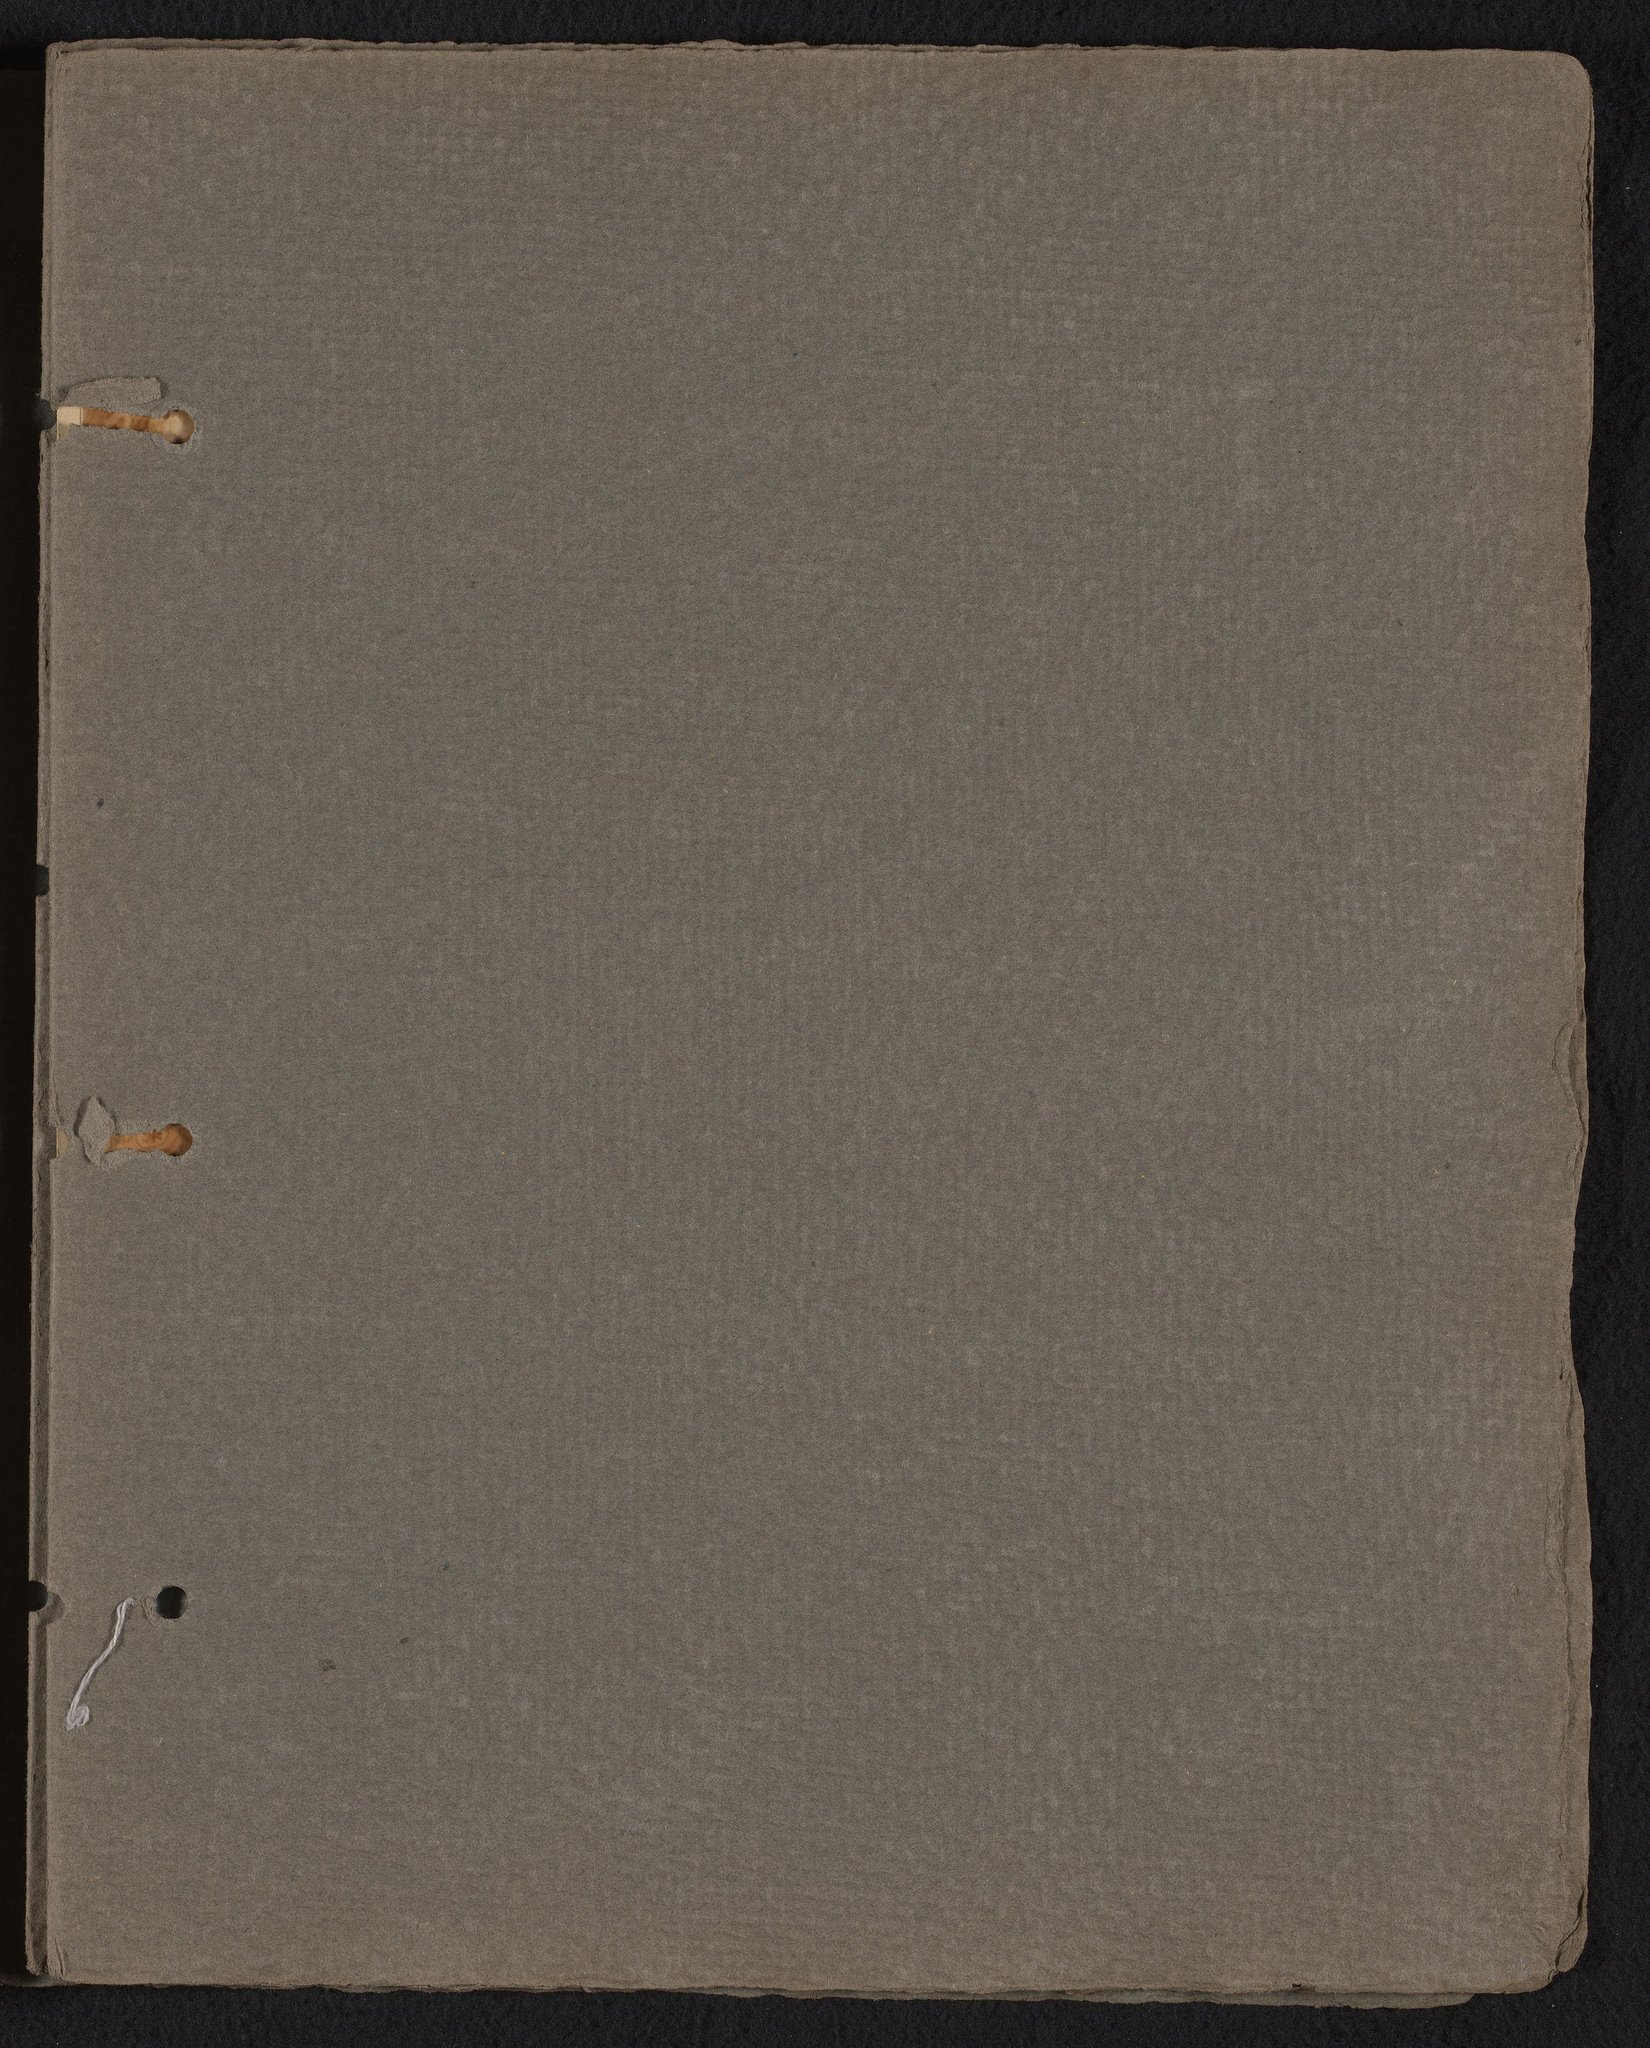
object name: wrapper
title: Omslag met een foto van Carel (Cay) van den Berg als peuter staand op een bank bij een raam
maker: Anonymous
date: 1900-1920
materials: paper, cardboard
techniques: gelatin silver print